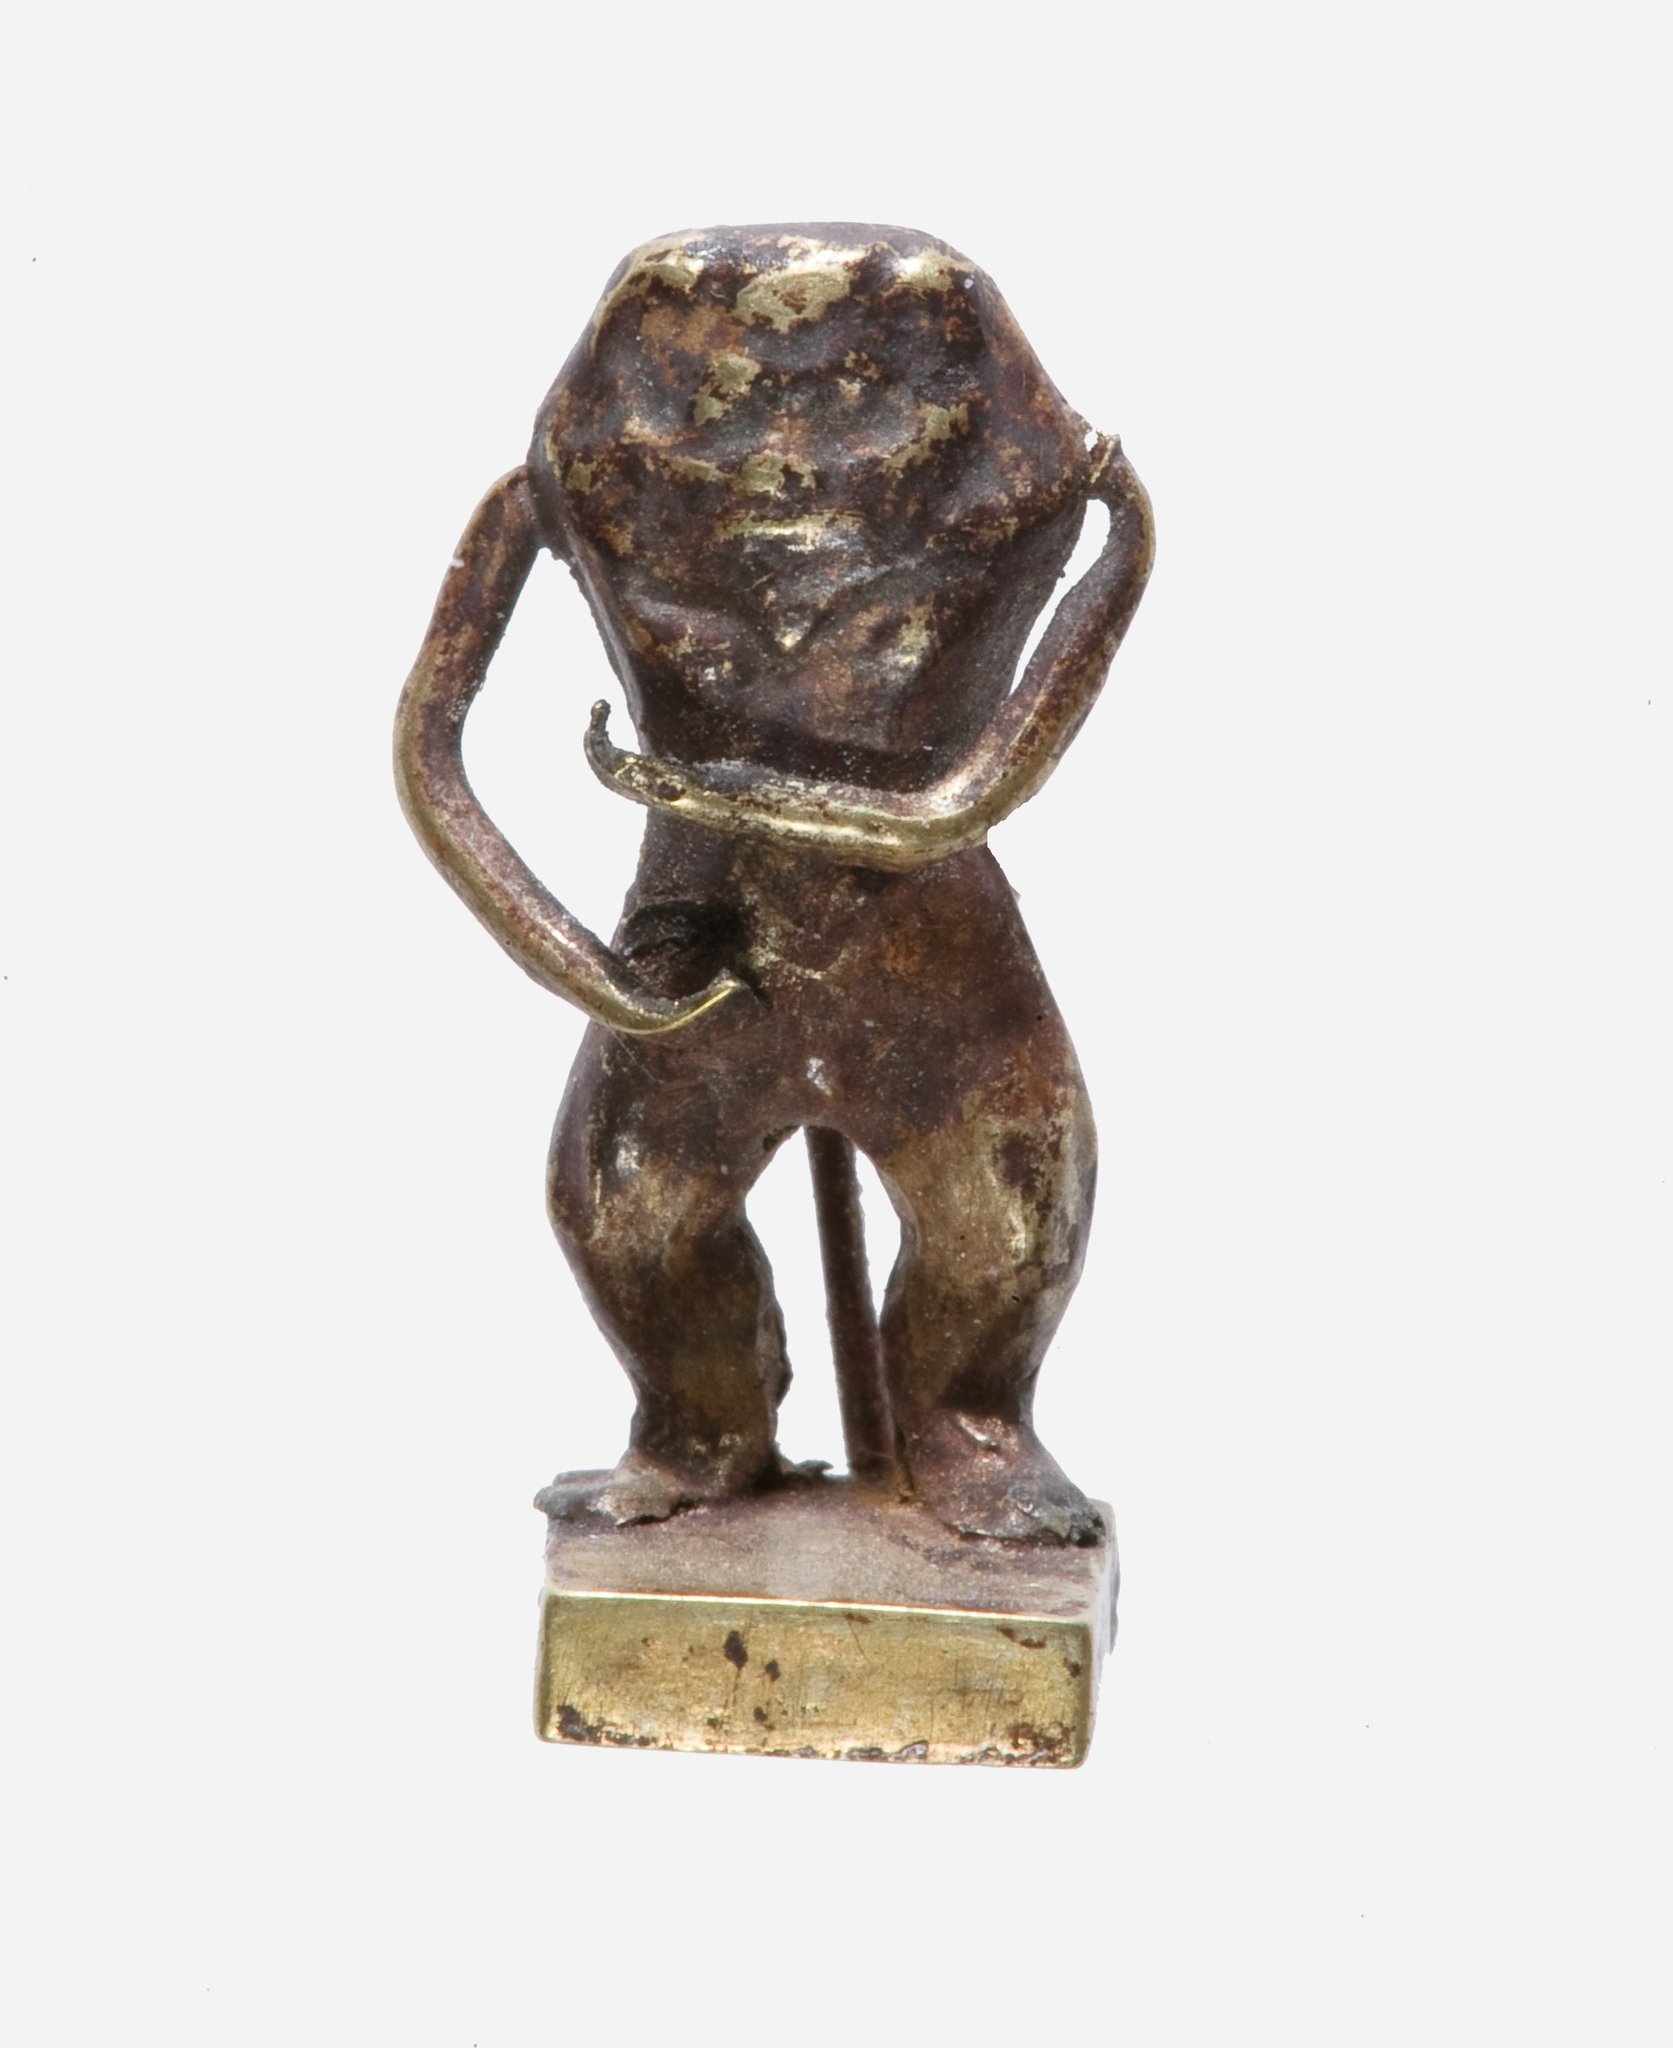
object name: figure of be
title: A standing figure of a Bes-image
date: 1950-1850 BCE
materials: gold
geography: egypt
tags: bes